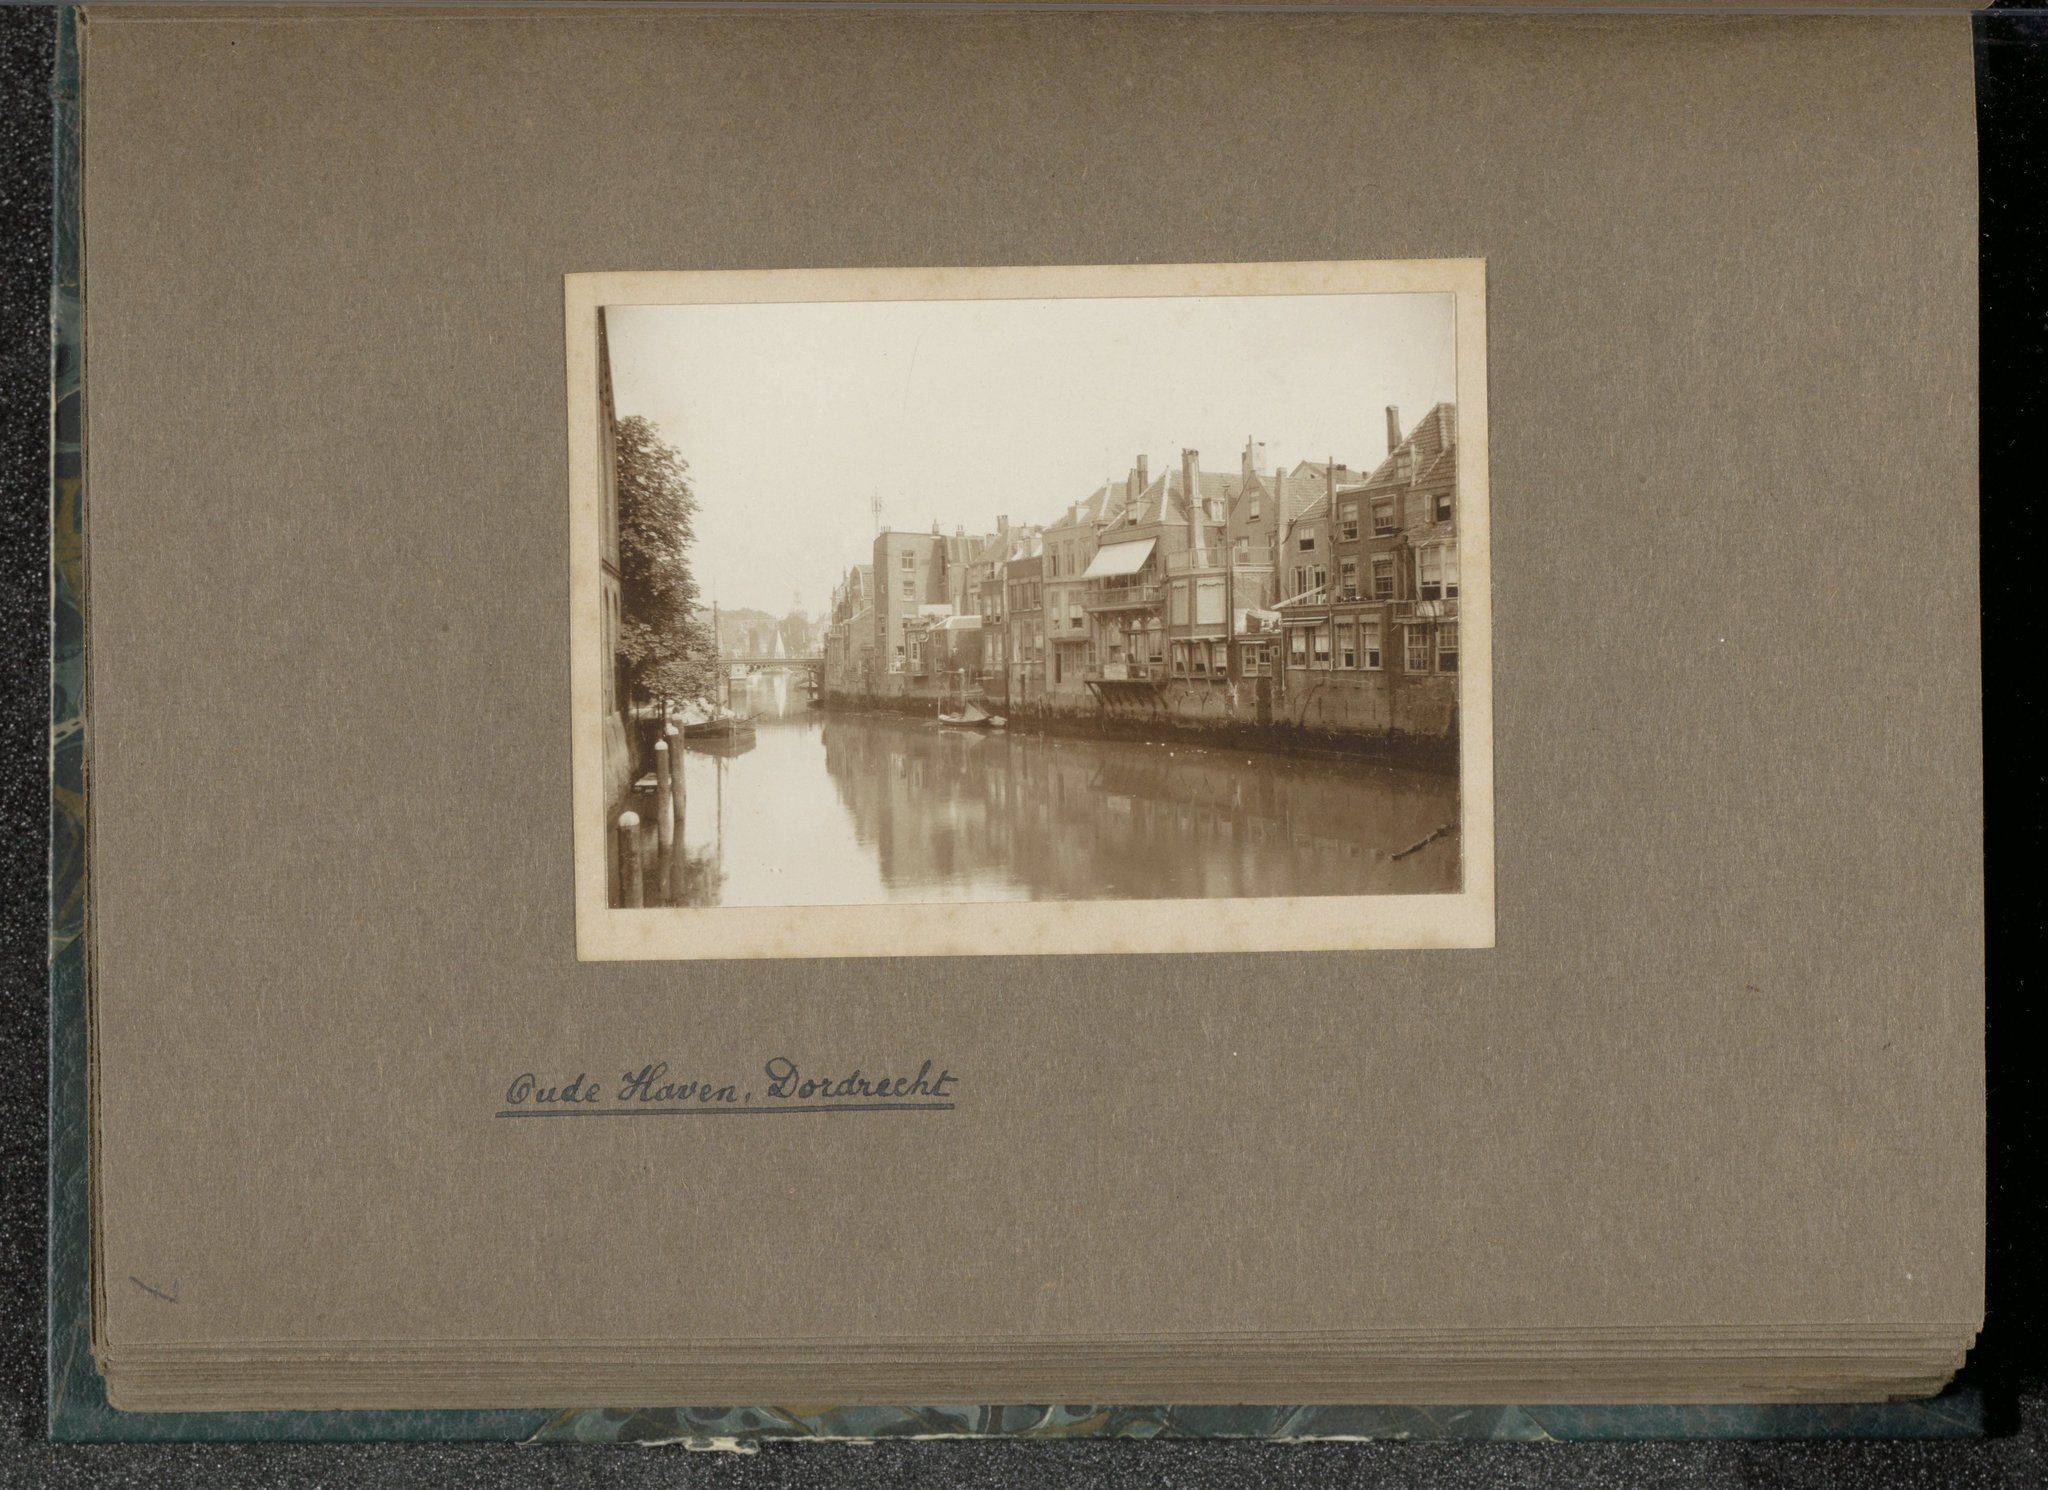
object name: photograph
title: Gezicht op de Voorstraatshaven in Dordrecht met op de achtergrond de Nieuwbrug en de Groothoofdspoort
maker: Anonymous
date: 1912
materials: cardboard, paper, photographic support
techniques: gelatin silver print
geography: dordrecht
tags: canal, travelling; tourism, bridge, city-gate, dordrecht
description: Onderdeel van Fotoalbum van de excursie naar Nederland van de Britse amateurfotografenvereniging P.C.U.K.